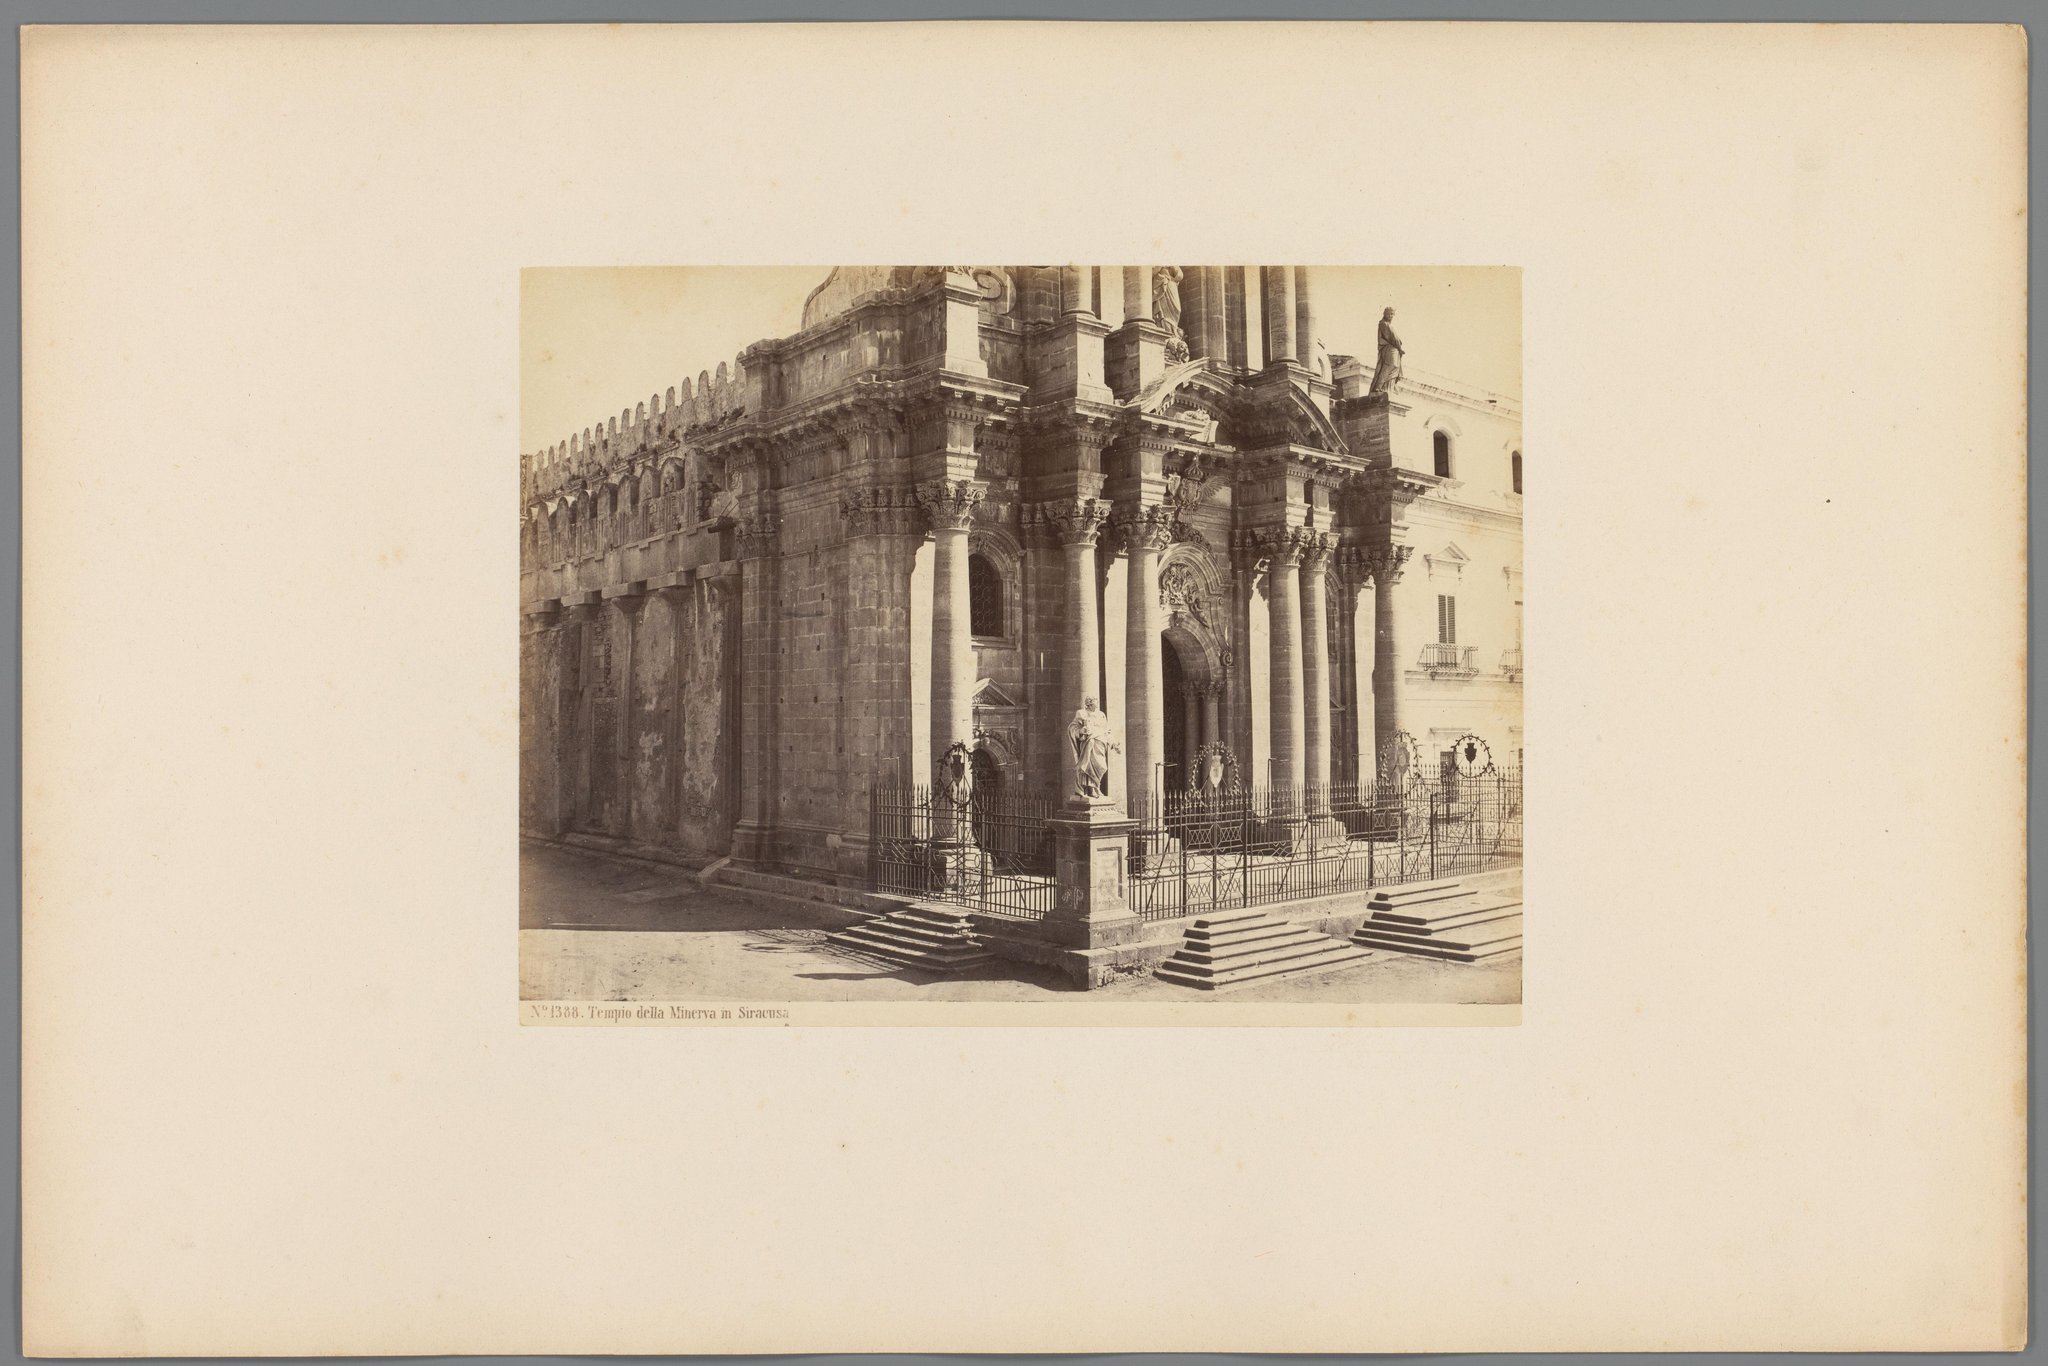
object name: photograph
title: Kathedraal van Syracuse, Italië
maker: Anonymous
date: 1851-1900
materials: cardboard, paper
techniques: albumen print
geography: syracuse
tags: church (exterior)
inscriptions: number: ‘No. 1388.’